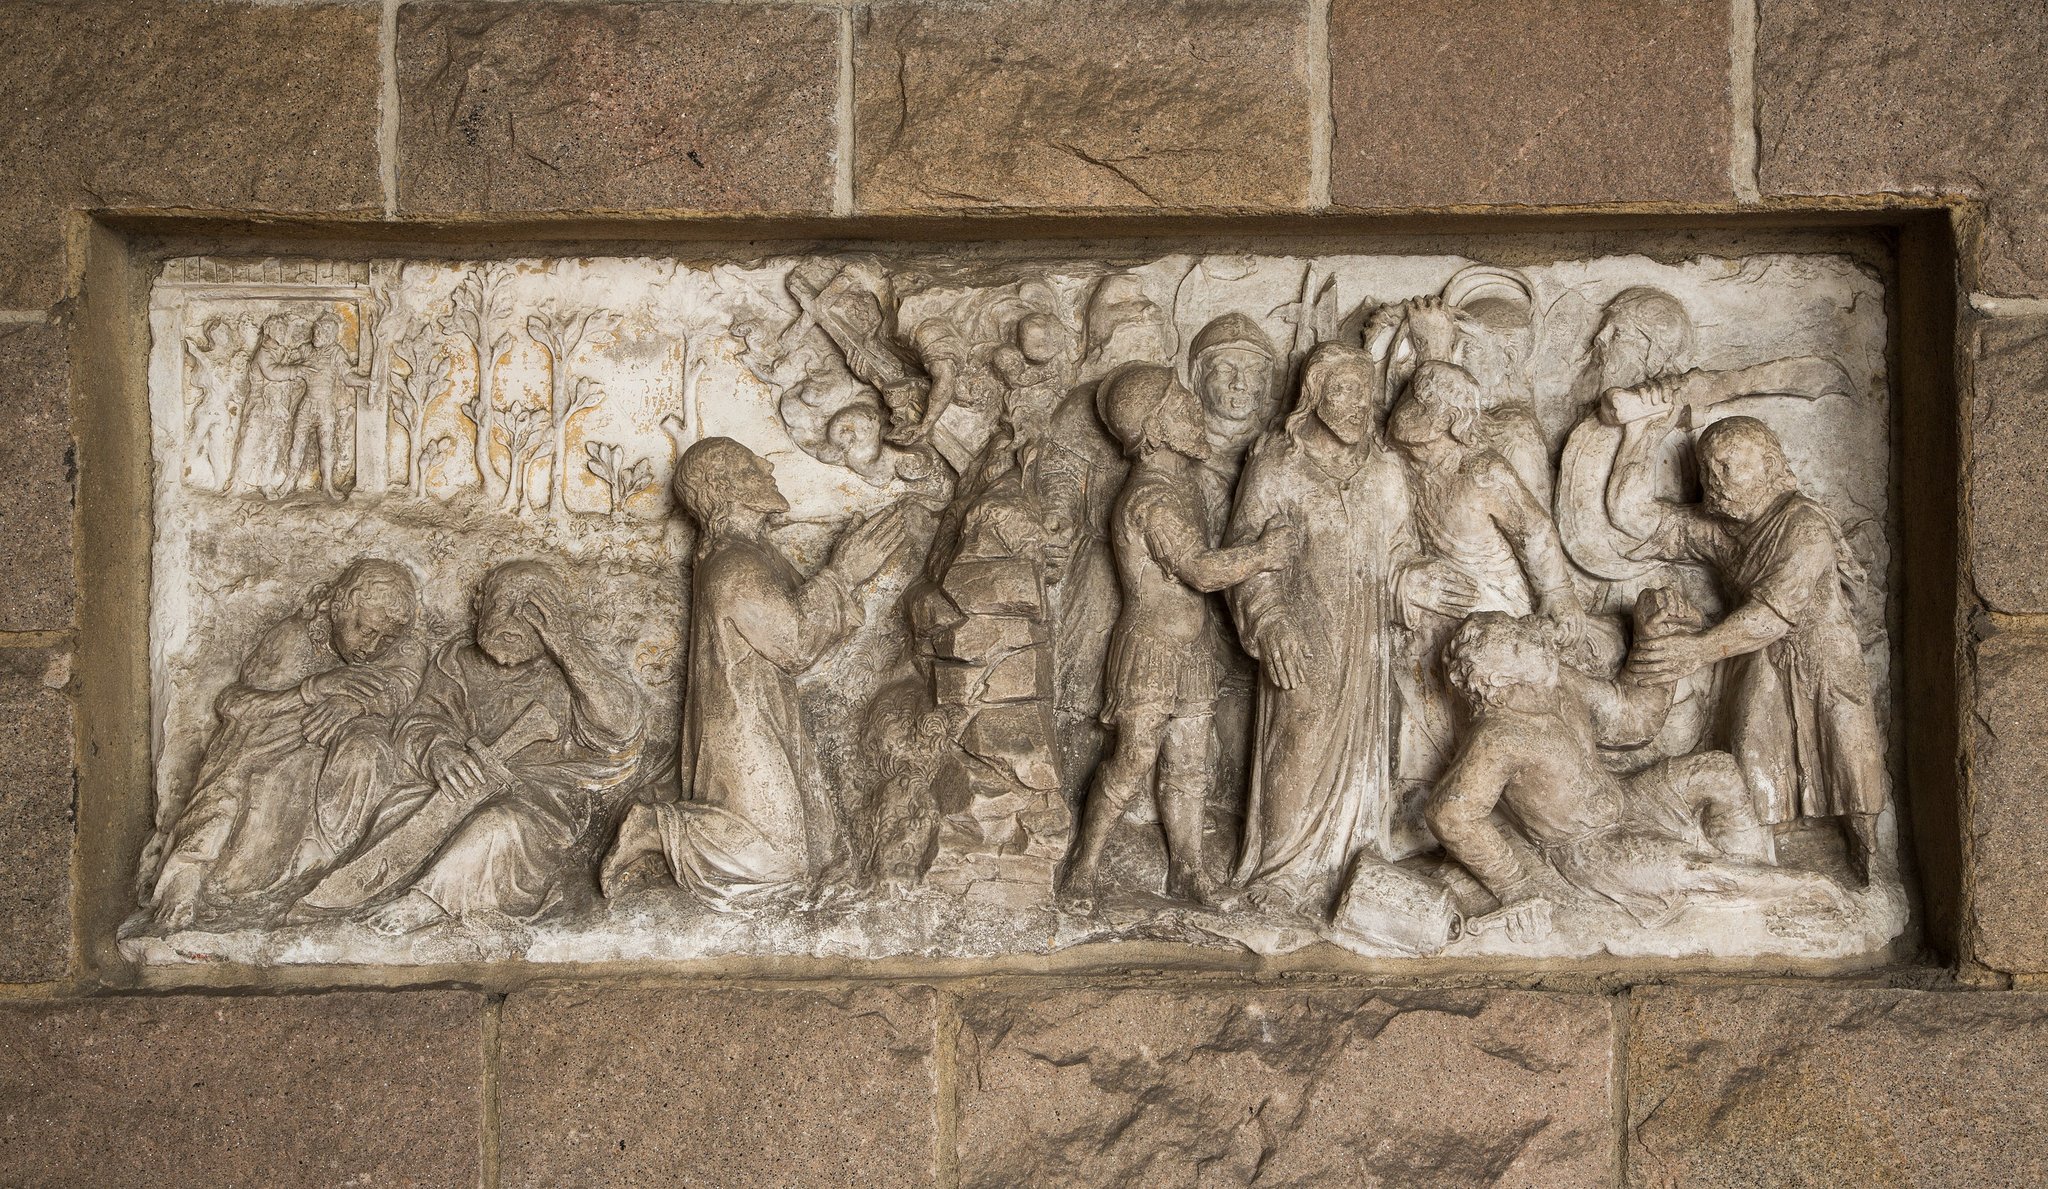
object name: relief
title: The Agony in the Garden and The Betrayal (from Scenes from the Passion of Christ)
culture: french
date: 1501-1533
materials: stone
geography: france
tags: soldiers,men,christ